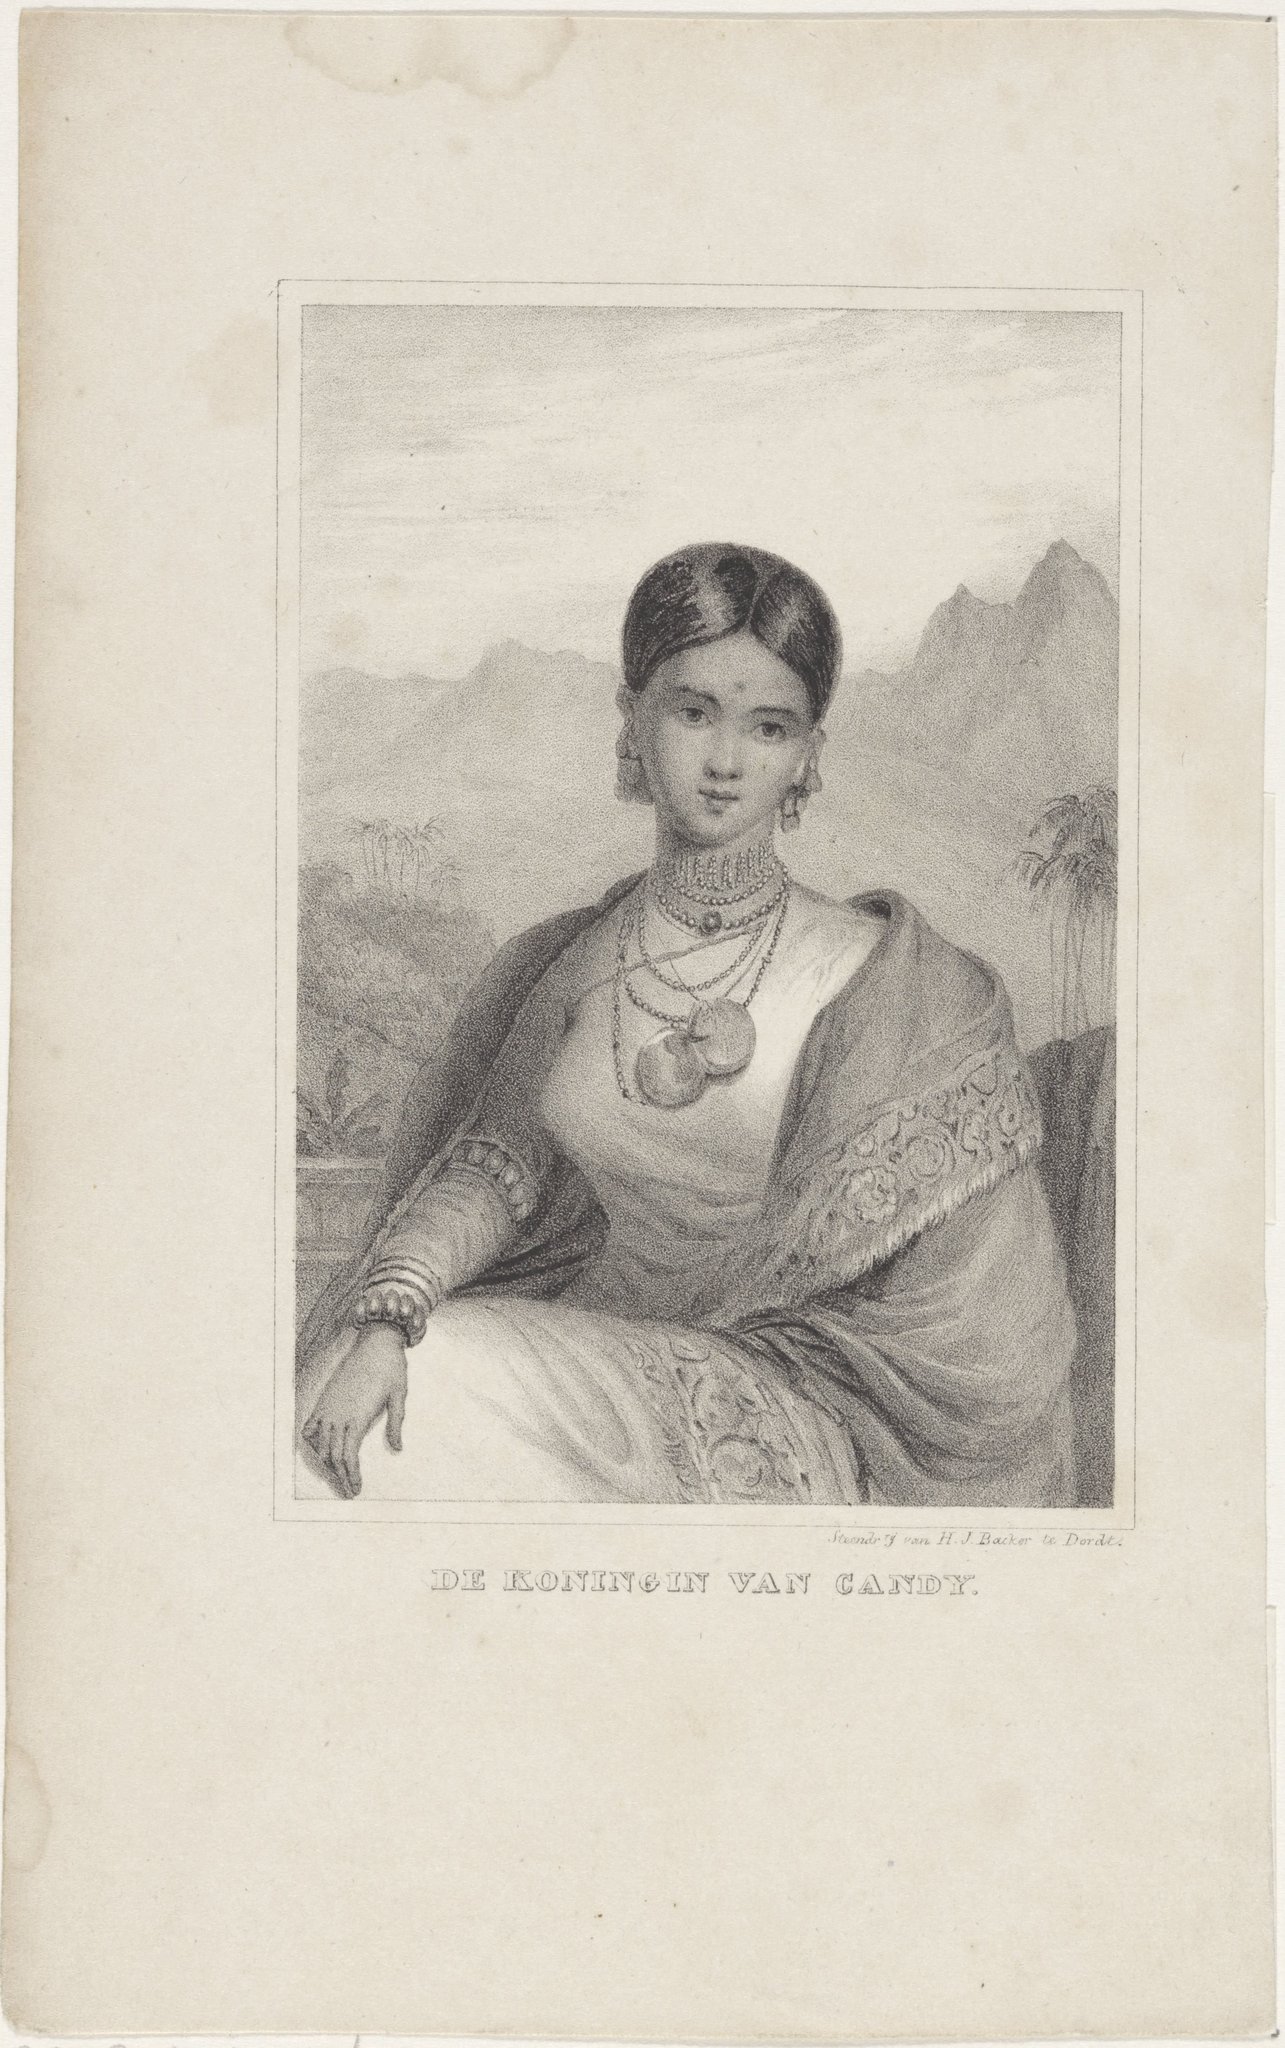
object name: print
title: De Koningin van Candy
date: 1822-1845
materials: paper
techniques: lithograph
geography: dordrecht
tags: historical persons - bb - woman, trees: palm-tree, necklace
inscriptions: collector's mark: Lugt 2228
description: De geportretteerde draagt een versierd gewaad en verschillende sieraden. In de achtergrond een bergachtig landschap en palmbomen. Op haar voorhoofd draagt zij een stip, een symbool binnen het Hindoeïsme.